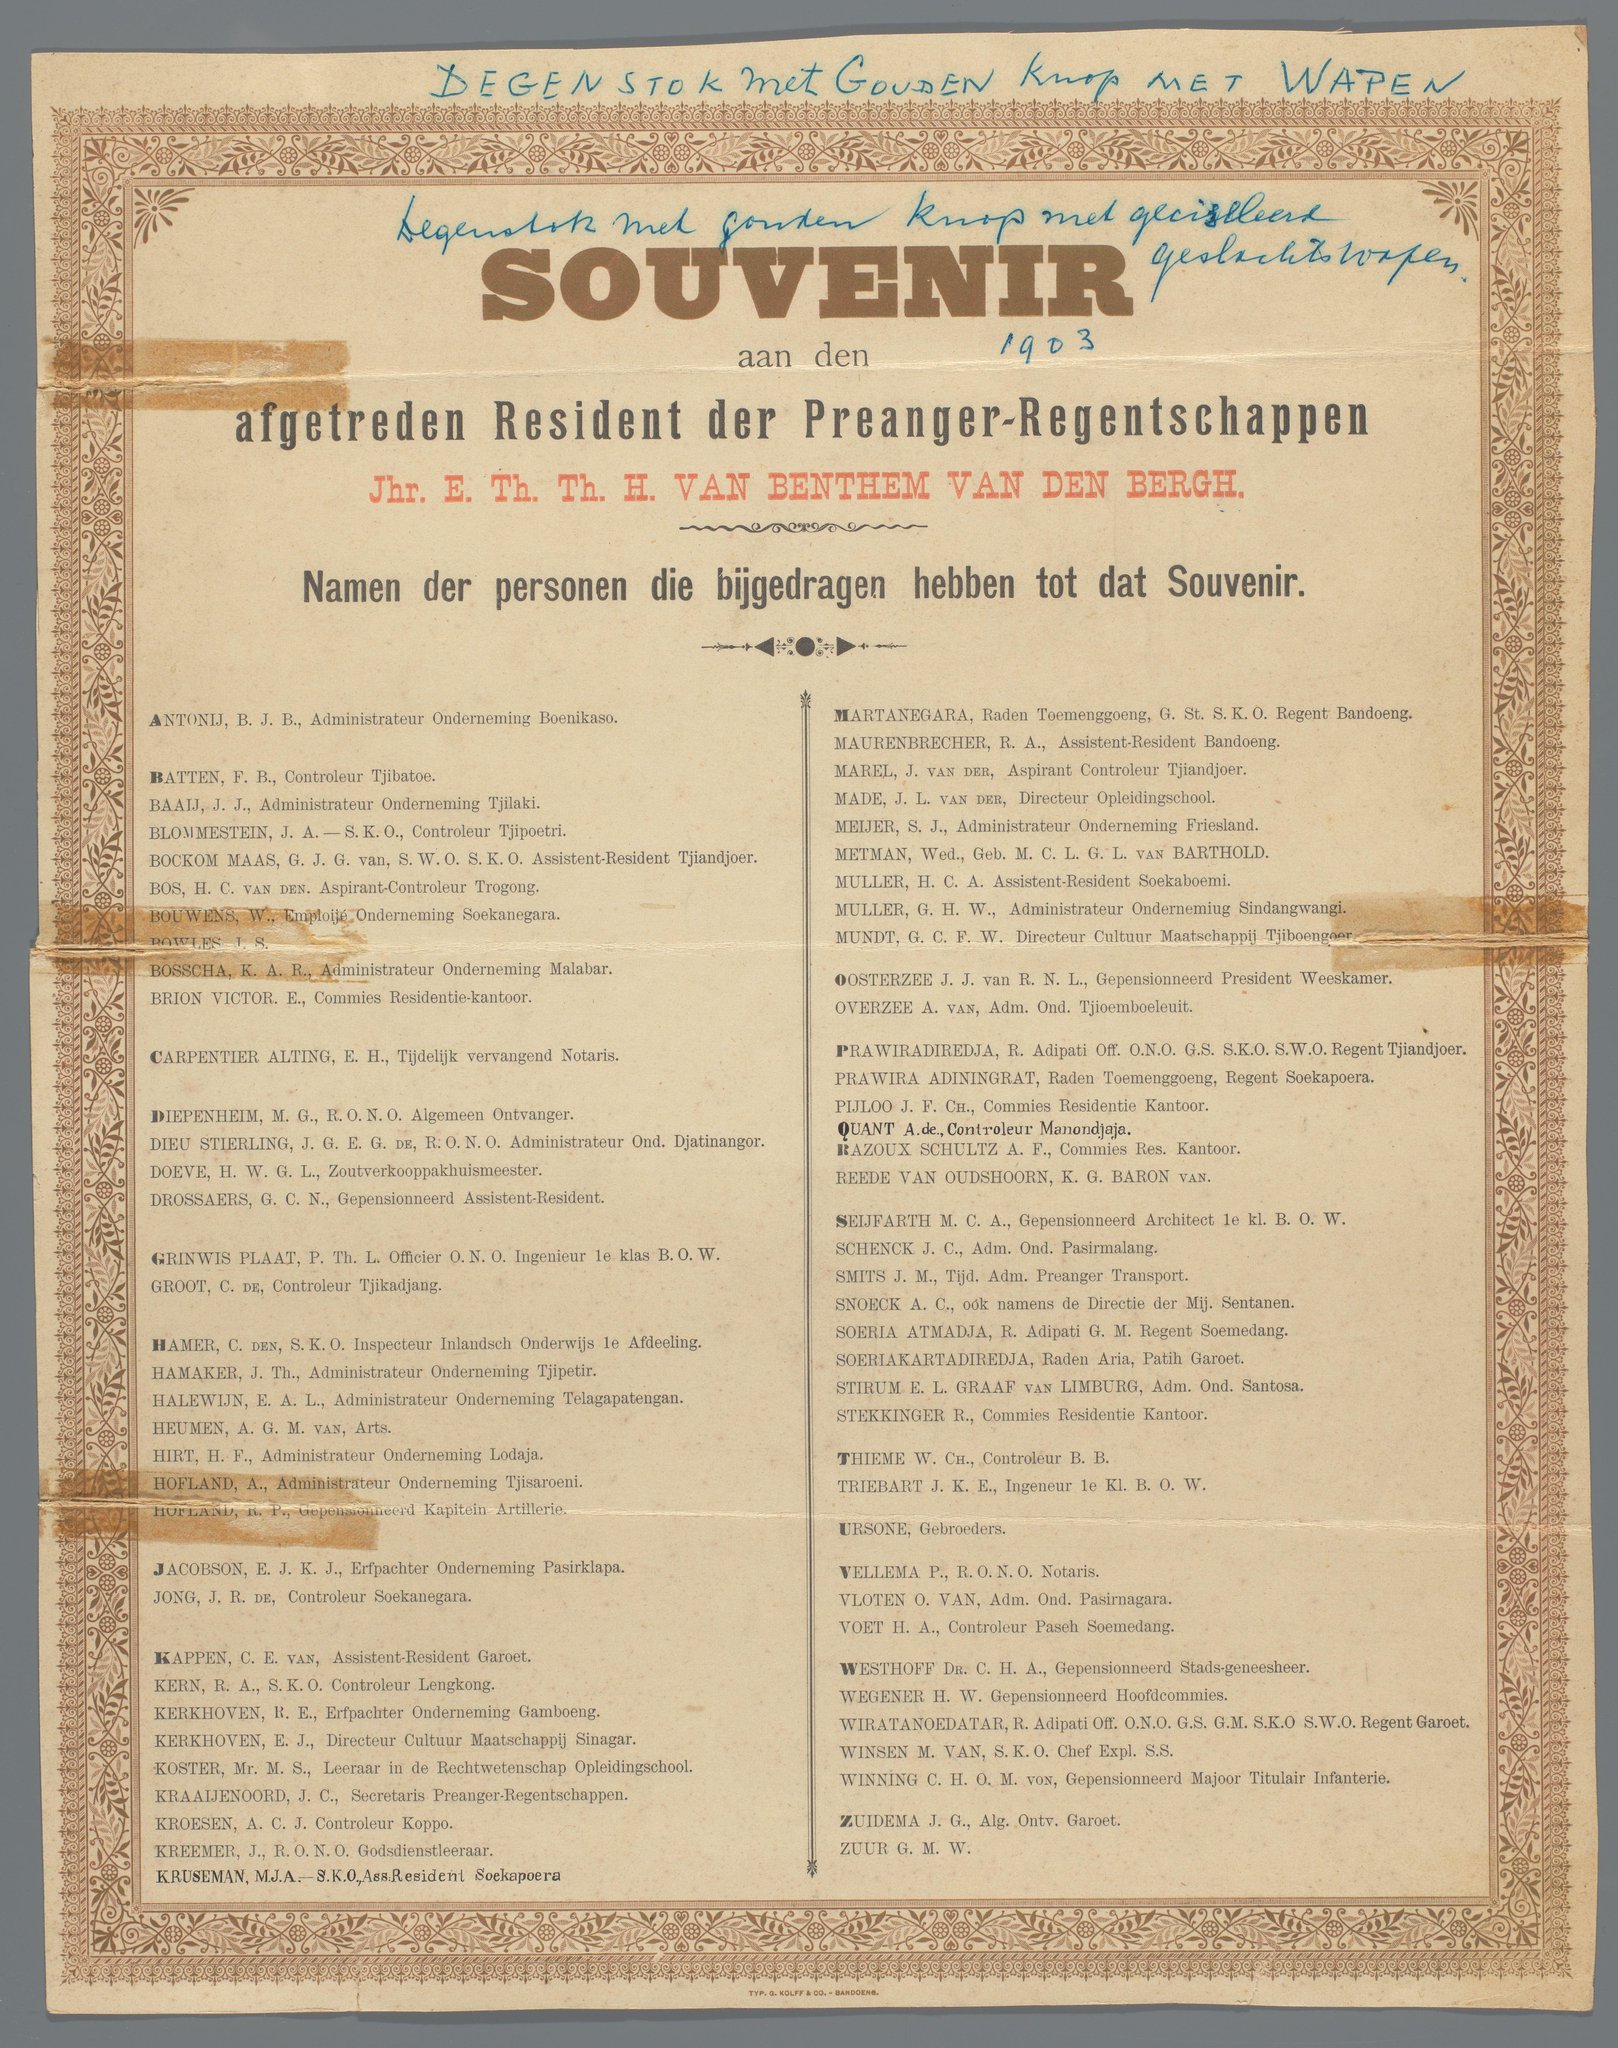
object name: document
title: Souvenir aan den afgetreden Resident der Preanger-Regentschappen Jhr. E.Th.H. van Benthem van den Bergh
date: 1903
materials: cardboard, ink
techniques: printing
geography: bandung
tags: zaltbommel, resident, jonkheer eduard thomas theodorus van benthem van den bergh, bandung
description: Nederlandse namen met personen die bijgedragen hebben aan de degenstok met gouden knop met geciseleerd geslachtswapen 1903, geschonken aan de afgetreden Resident der Preanger-Regentschappen Jhr. E.Th.H. van Benthem van den Bergh. Tekst gedrukt in zwart en rood met gouden versierd kader. Aan de bovenrand is met balpoint geschreven.